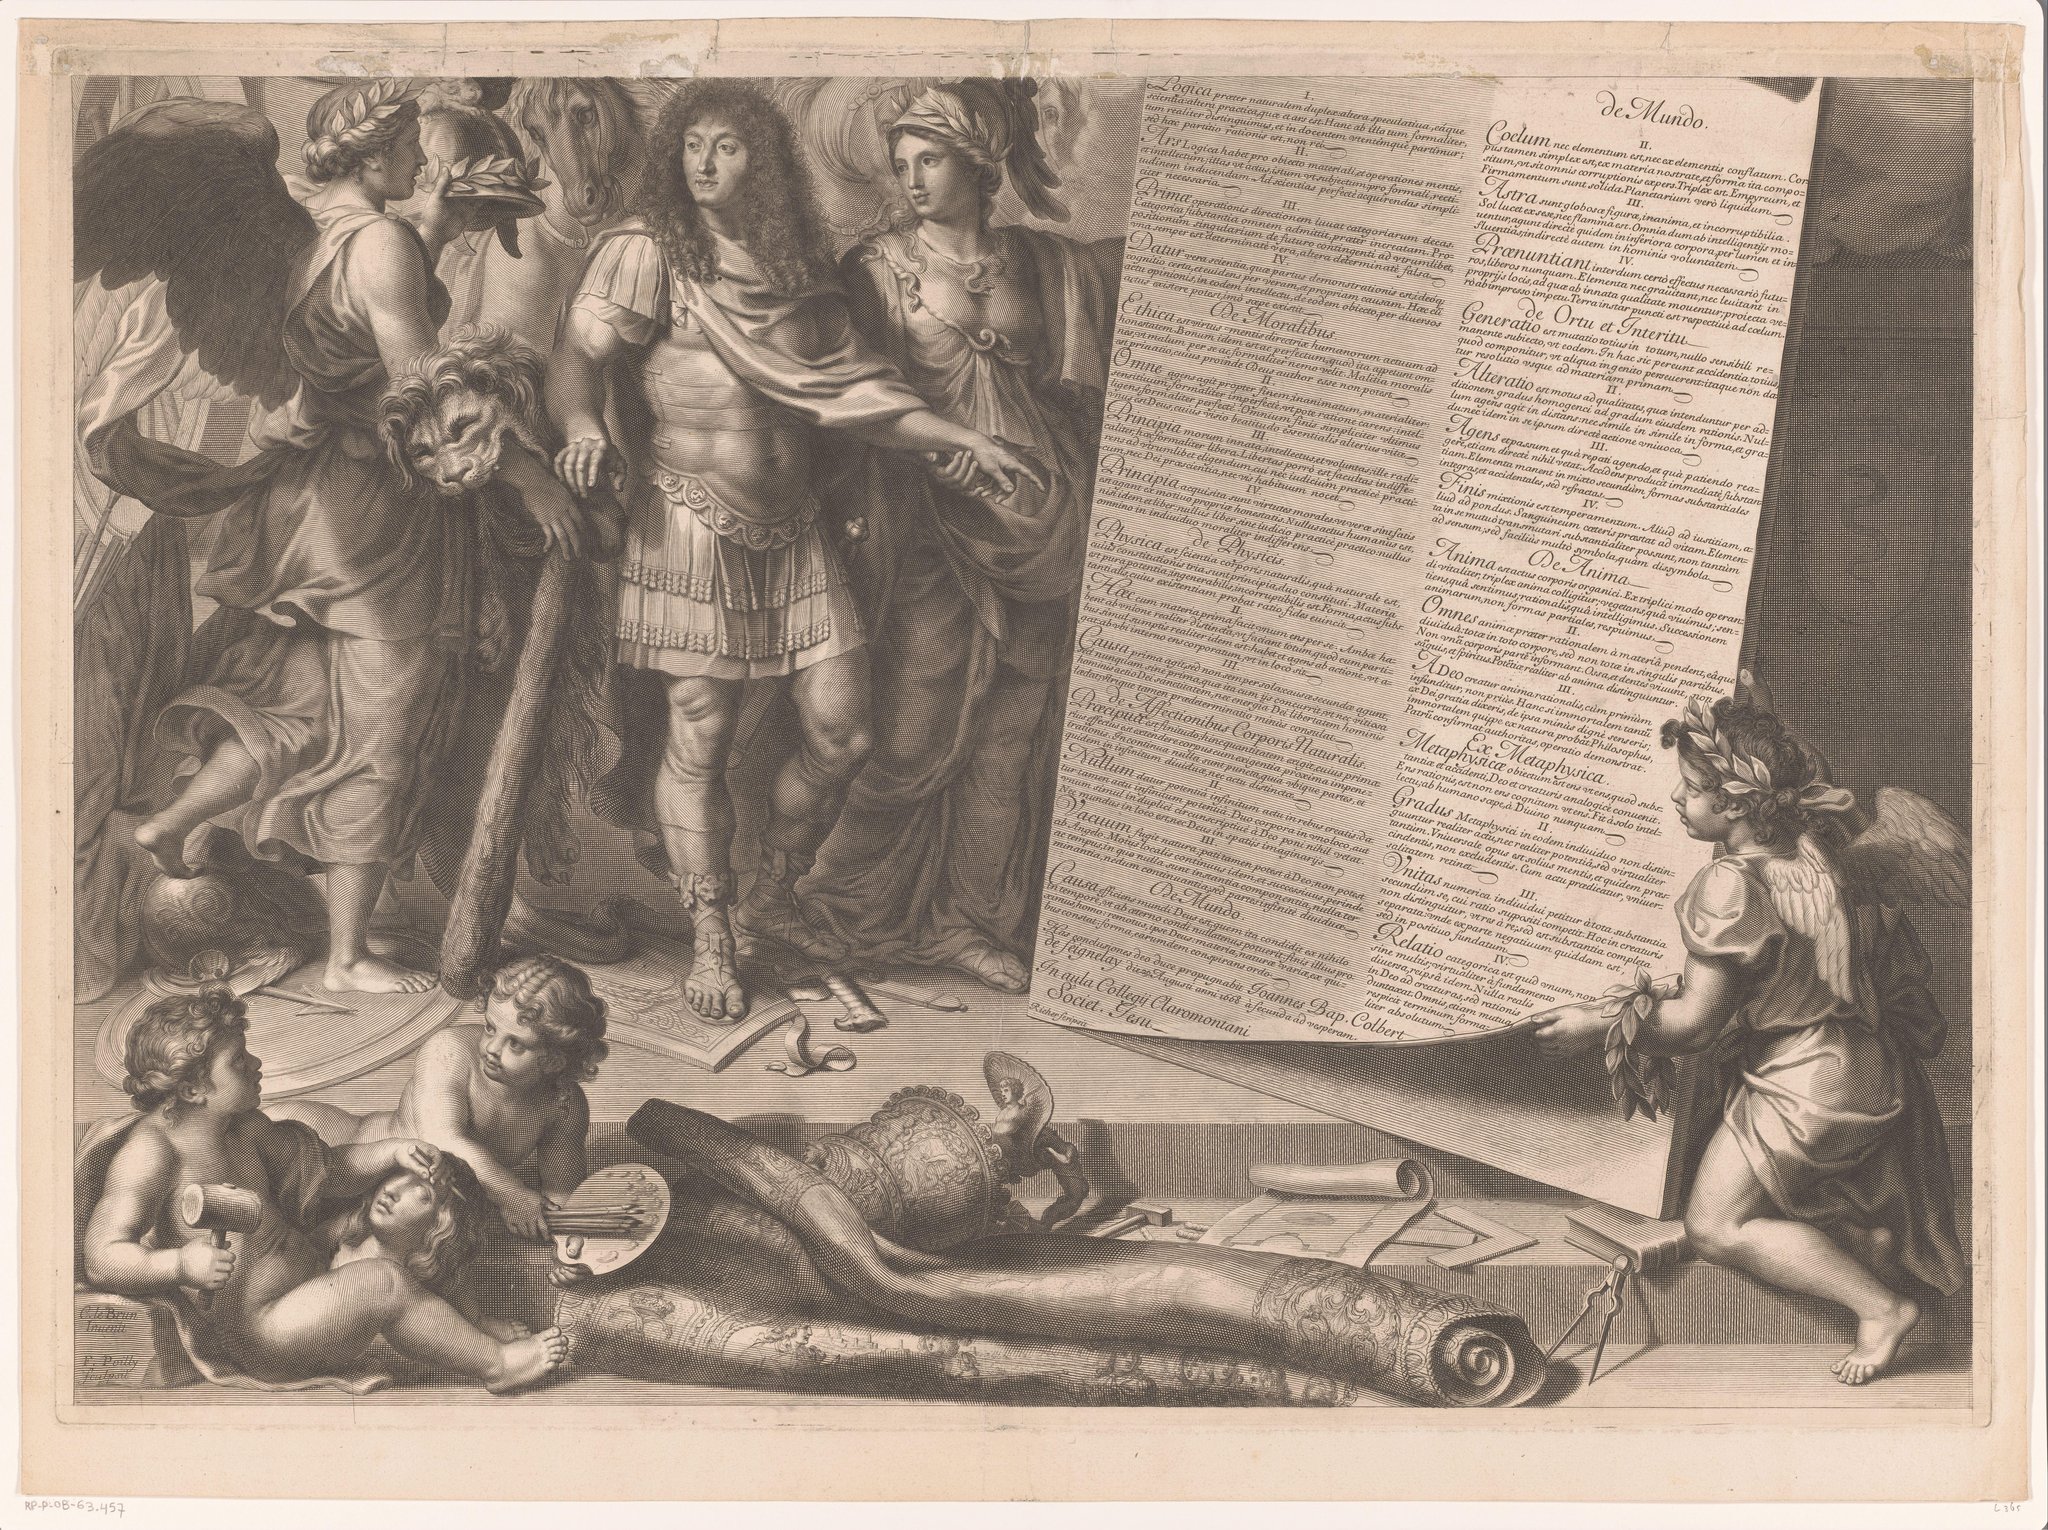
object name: print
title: Allegorie op Lodewijk XIV (onderste deel)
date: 1668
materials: paper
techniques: engraving, etching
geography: france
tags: lodewijk xiv (koning van frankrijk), (story of) minerva (pallas, athena), attributes of hercules, victory, cupids: 'amores', 'amoretti', 'putti', king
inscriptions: collector's mark: Lugt 240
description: These van Jean-Baptiste Colbert de Seignelay opgedragen aan Lodewijk XIV. Minerva en Wetenschap leiden de koning naar de tekst van de these, Victorie biedt hem de attributen van Hercules aan.